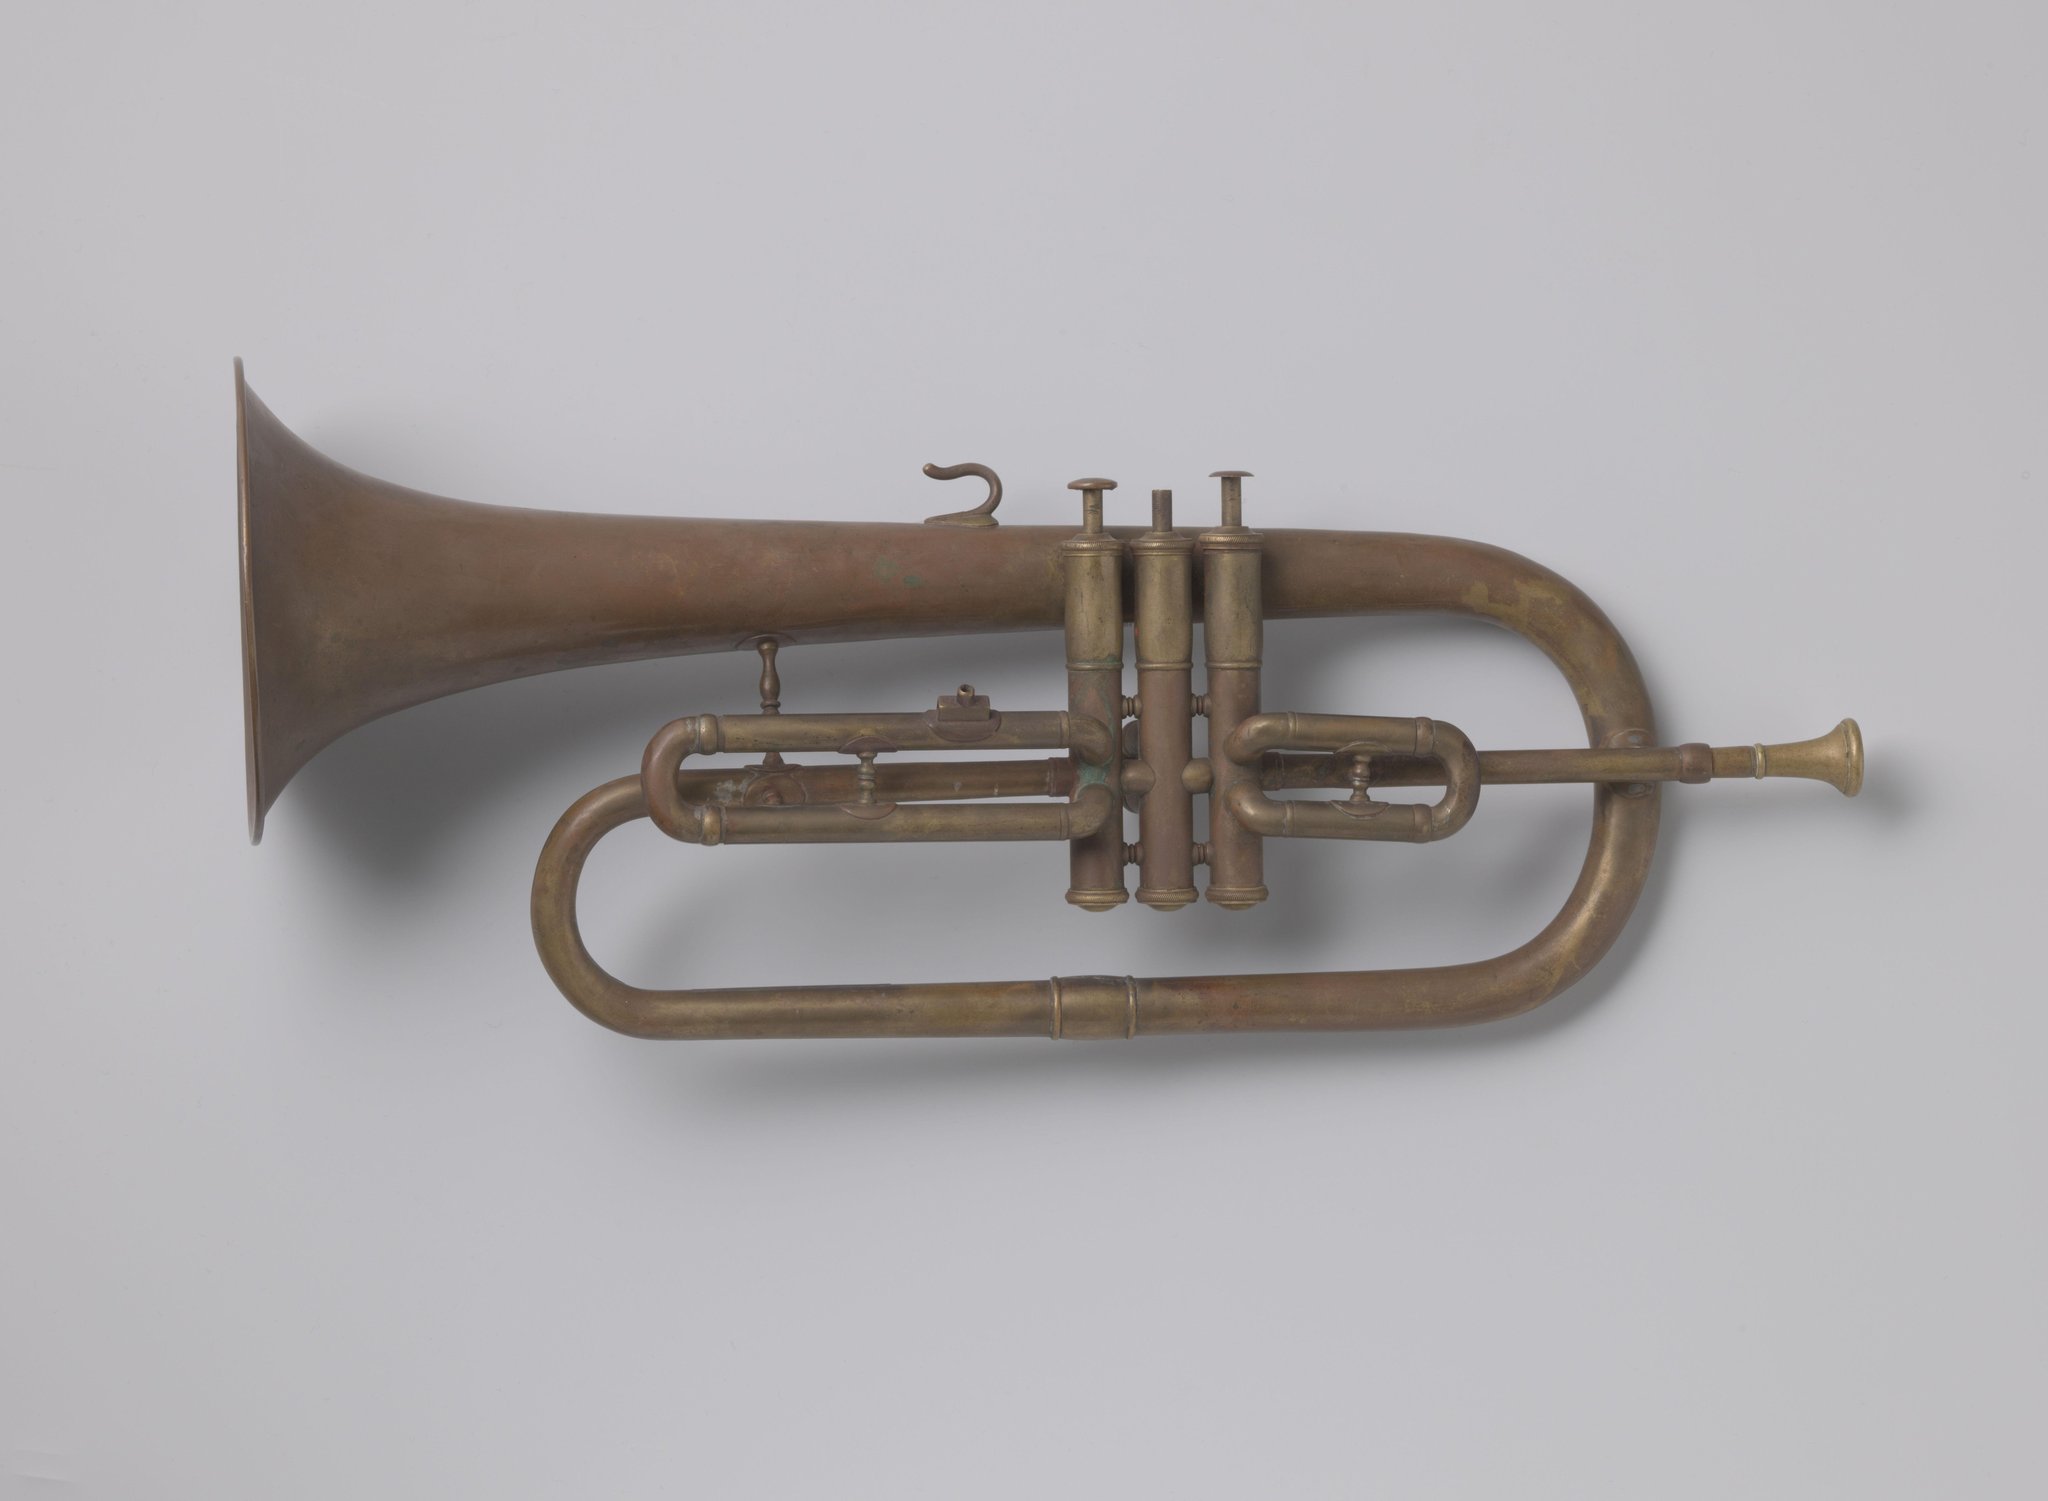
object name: musical instrument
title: Bugle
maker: egidius petrus van osch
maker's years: 1822-1885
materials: copper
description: Bugel in B. Drie Périnet-ventielen, genummerd 1, 2 en 3, die de grondtoon verlagen met respectievelijk 1, 1/2 en 1 en 1/2 toon. Met houdertje voor muziekstandaard en steunhaak voor de pink van de rechterhand. Op de beker een ovaal brandstempel: 'E. P. van Osch / Brevete / Maastricht'. Vlak bij de bekerrand is ingeslagen: '4.R.I.1868' (4e REGIMENT INFANTERIE 1868). Het instrument werd in 1868 door het 4e Regiment Infanterie van het Nederlandse leger in gebruik genomen.